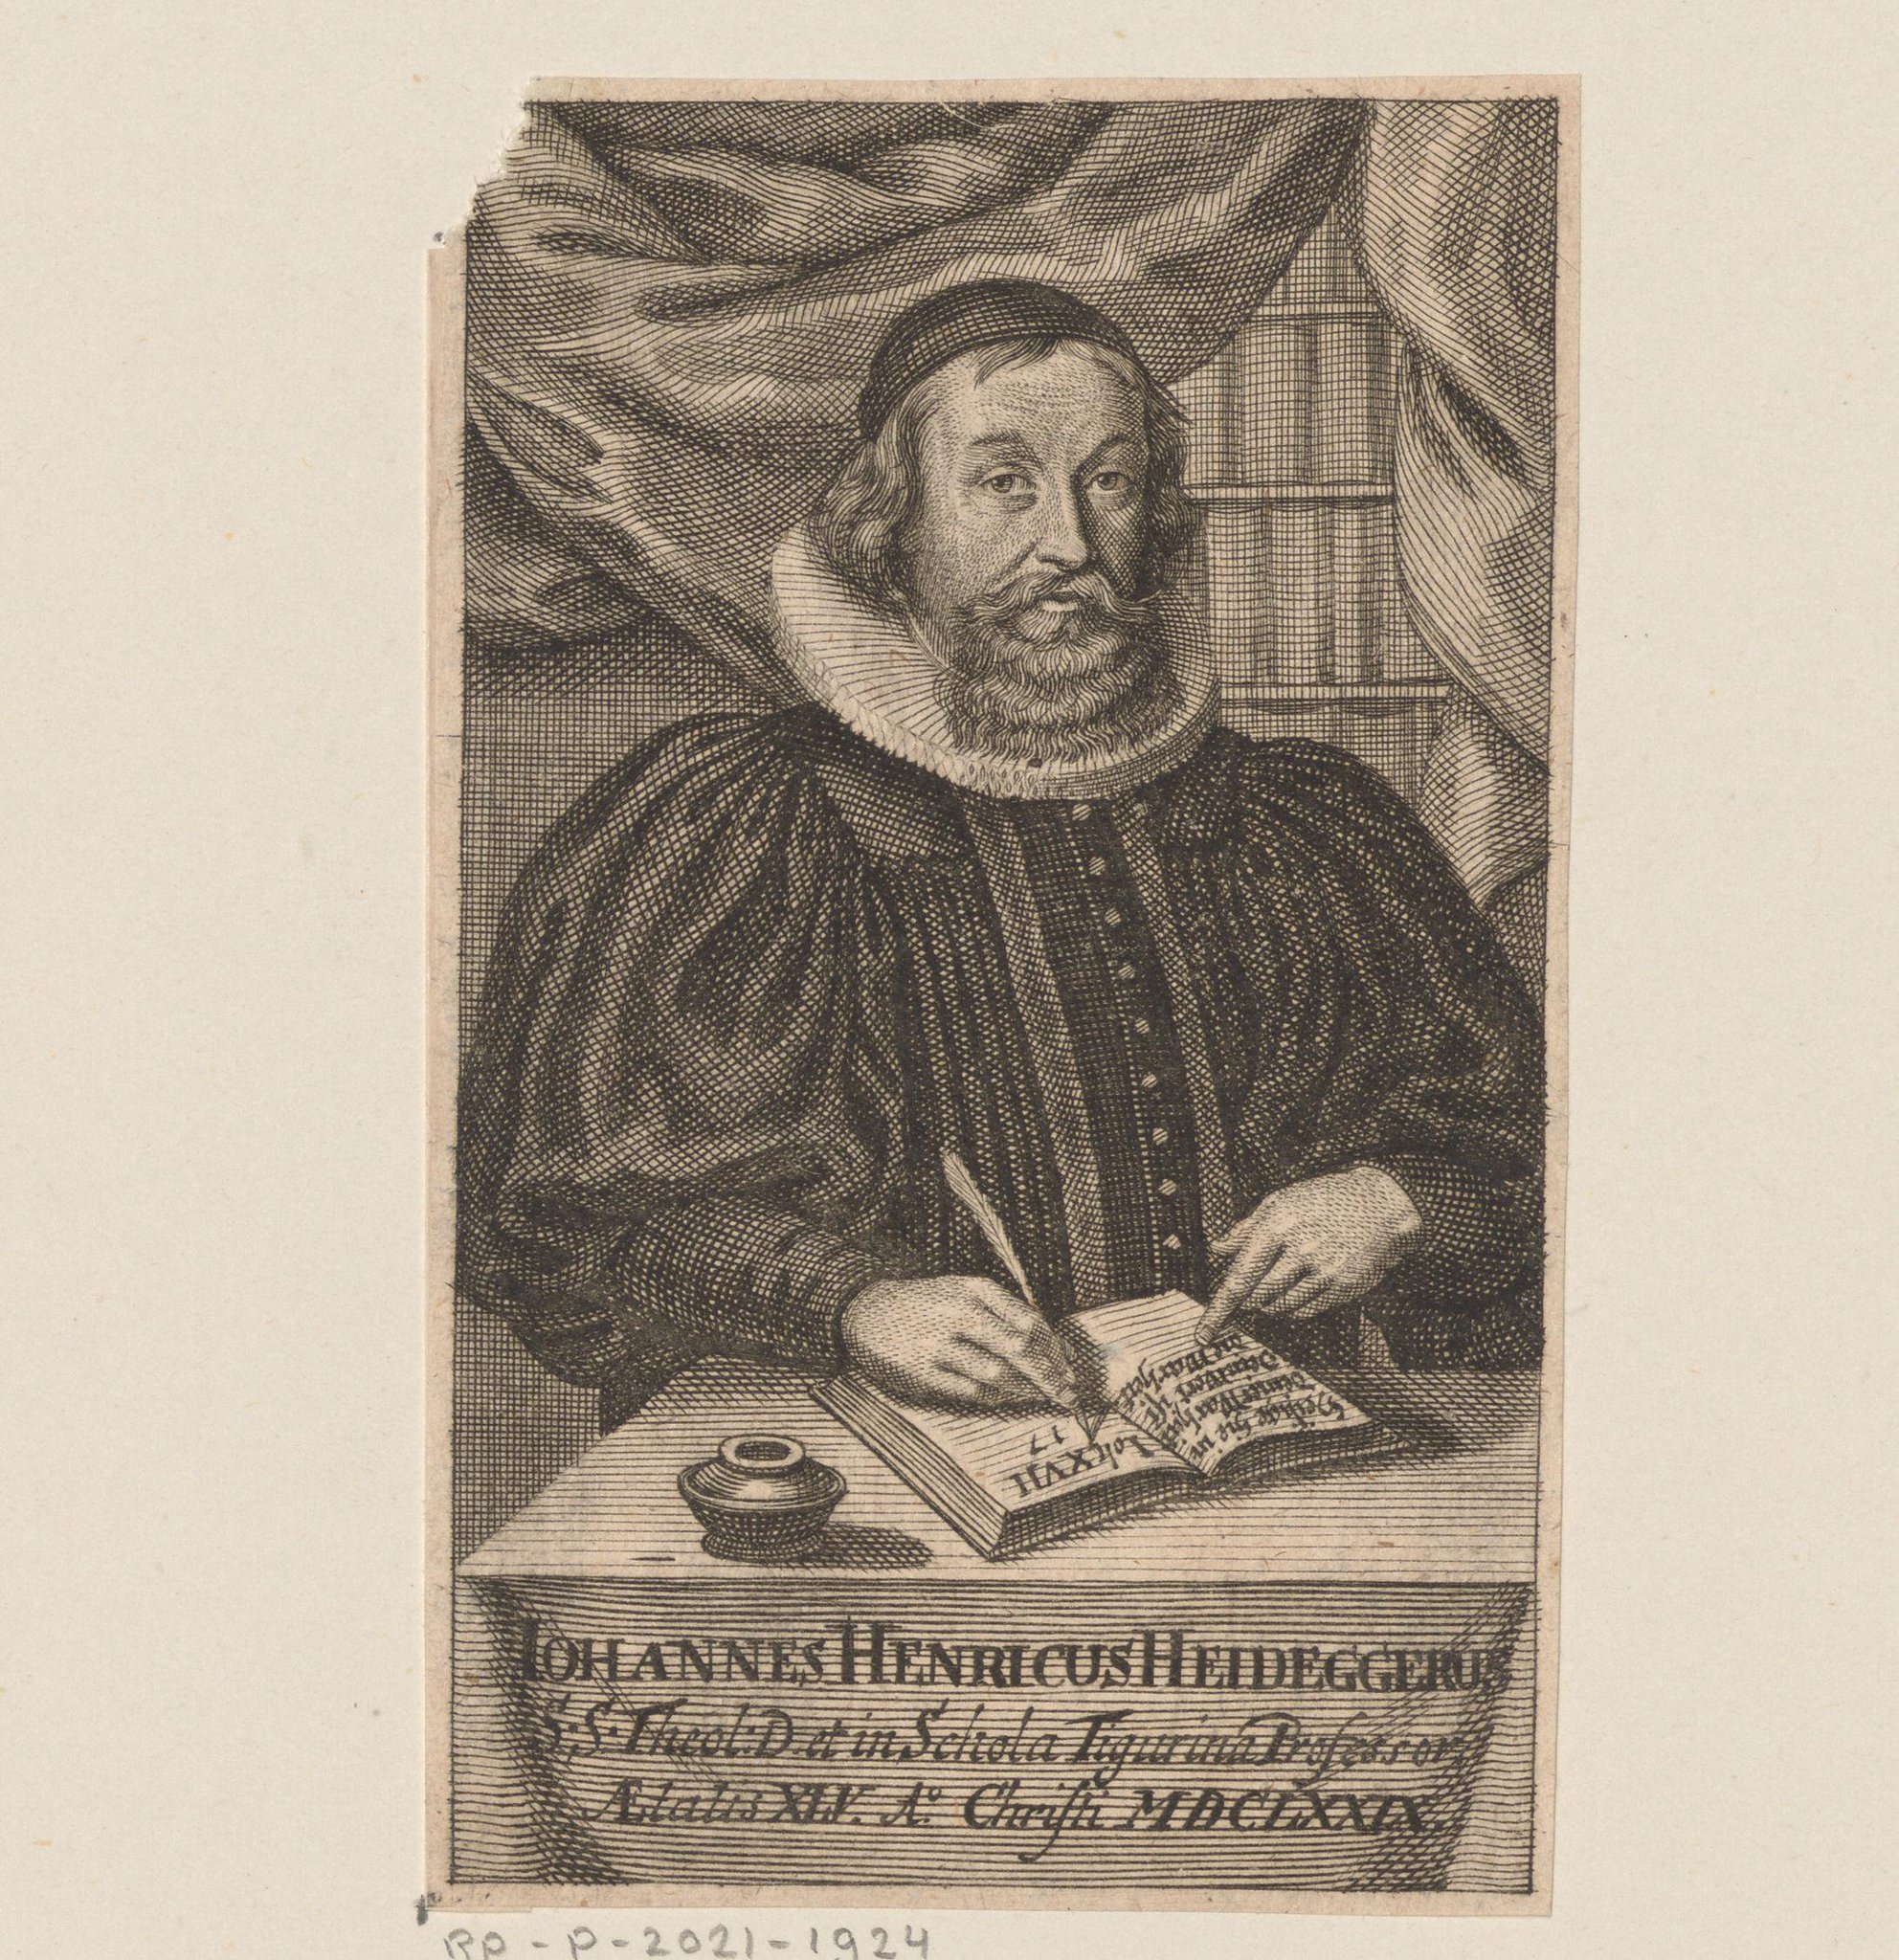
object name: print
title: Portret van Johann Heinrich Heidegger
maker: Anonymous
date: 1679-1724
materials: paper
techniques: engraving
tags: switzerland, historical persons, book, professor